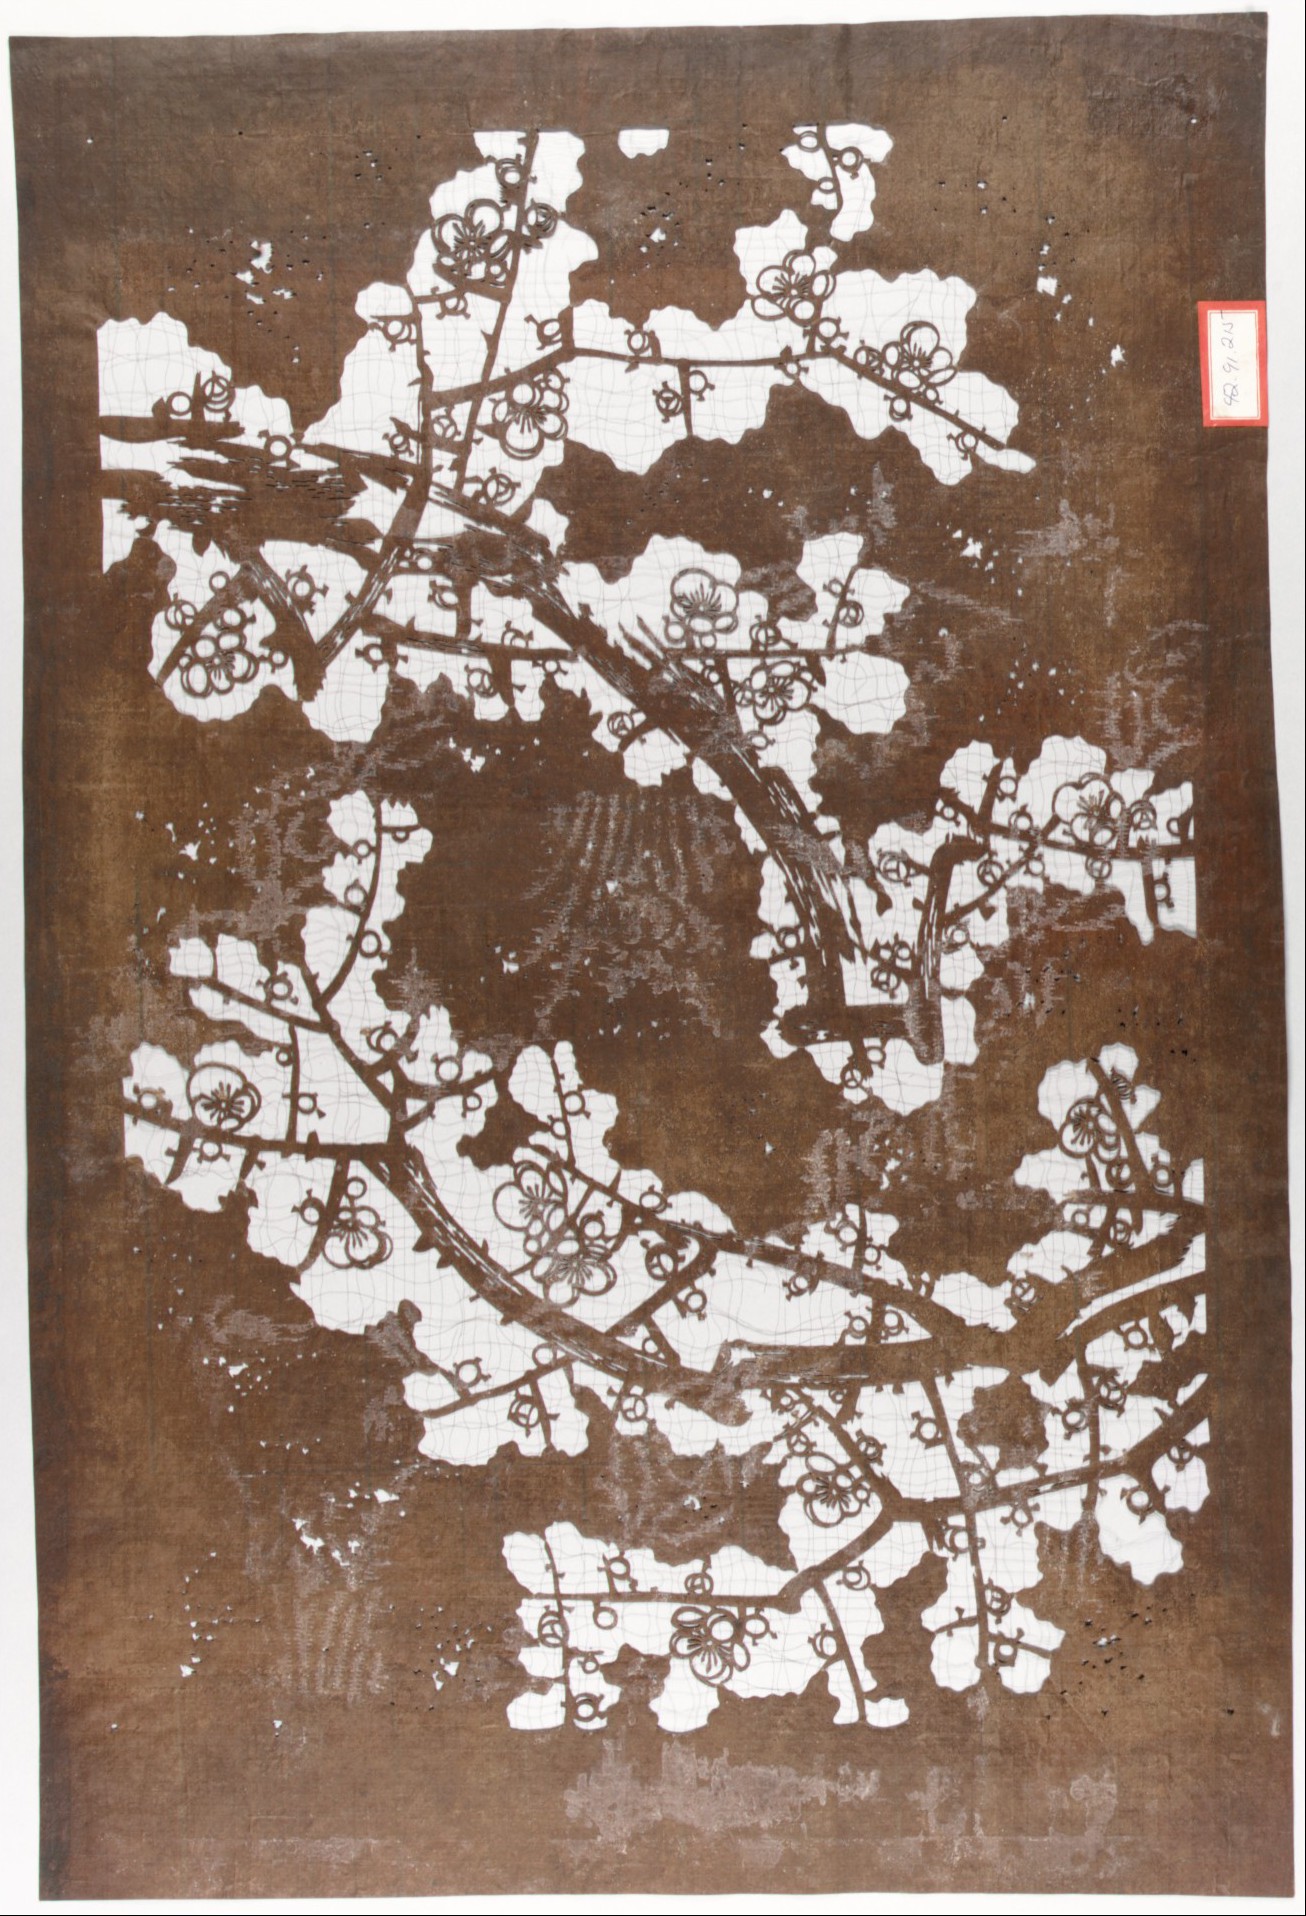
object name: stencil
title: Stencil with Plum Blossoms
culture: japanese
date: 1801-1900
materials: paper, silk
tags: flowers